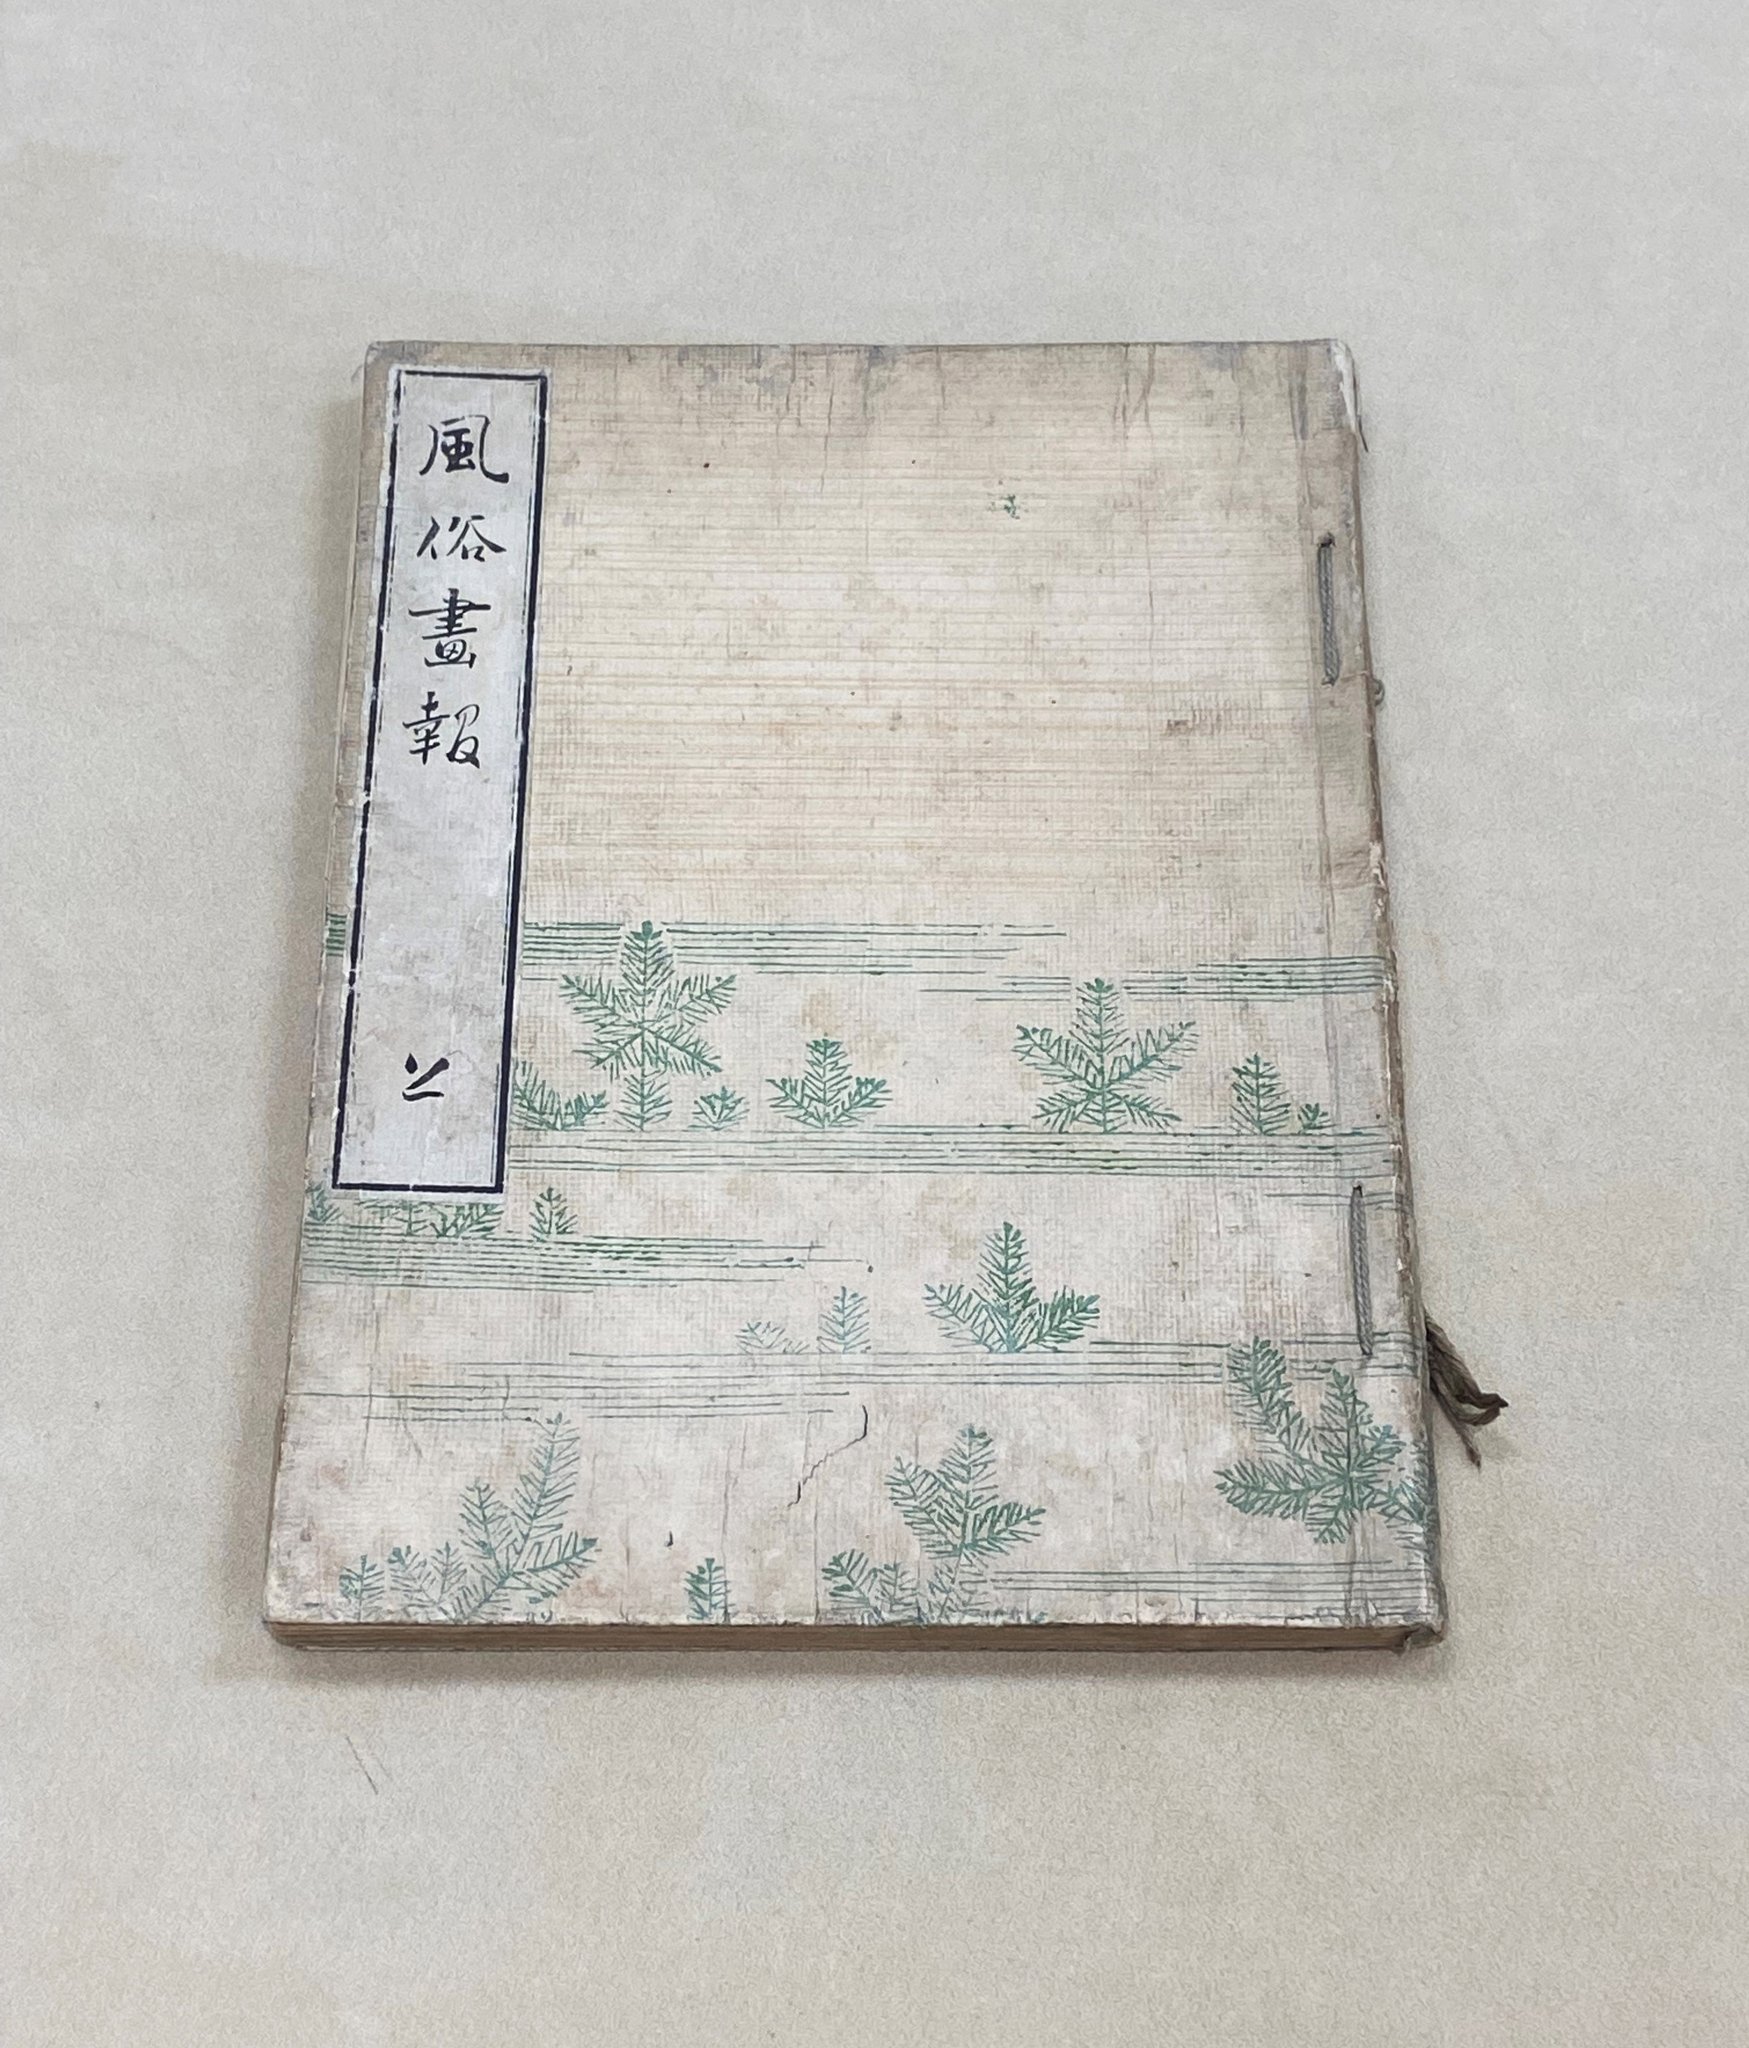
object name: illustrated book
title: Fūzoku gahō (Illustrated Customs) Vol. 1 (issues 1–10)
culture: japanese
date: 1889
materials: ink, paper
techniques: woodblock print